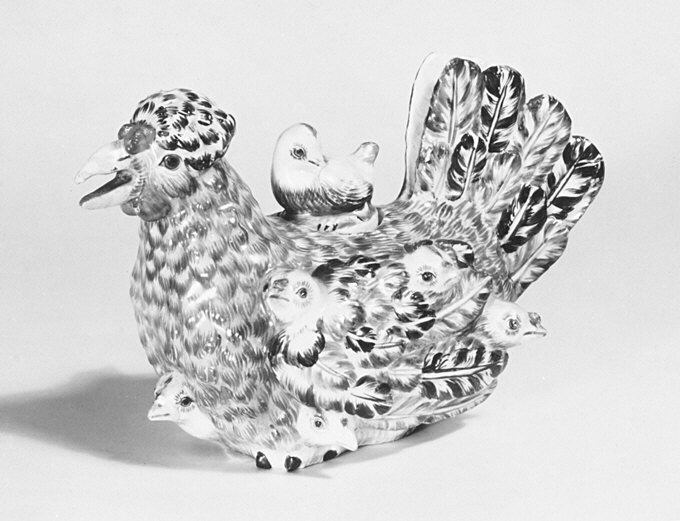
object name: teapot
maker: meissen manufactory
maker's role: manufactory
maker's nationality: german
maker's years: 1710-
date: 1745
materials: hard paste porcelain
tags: chickens